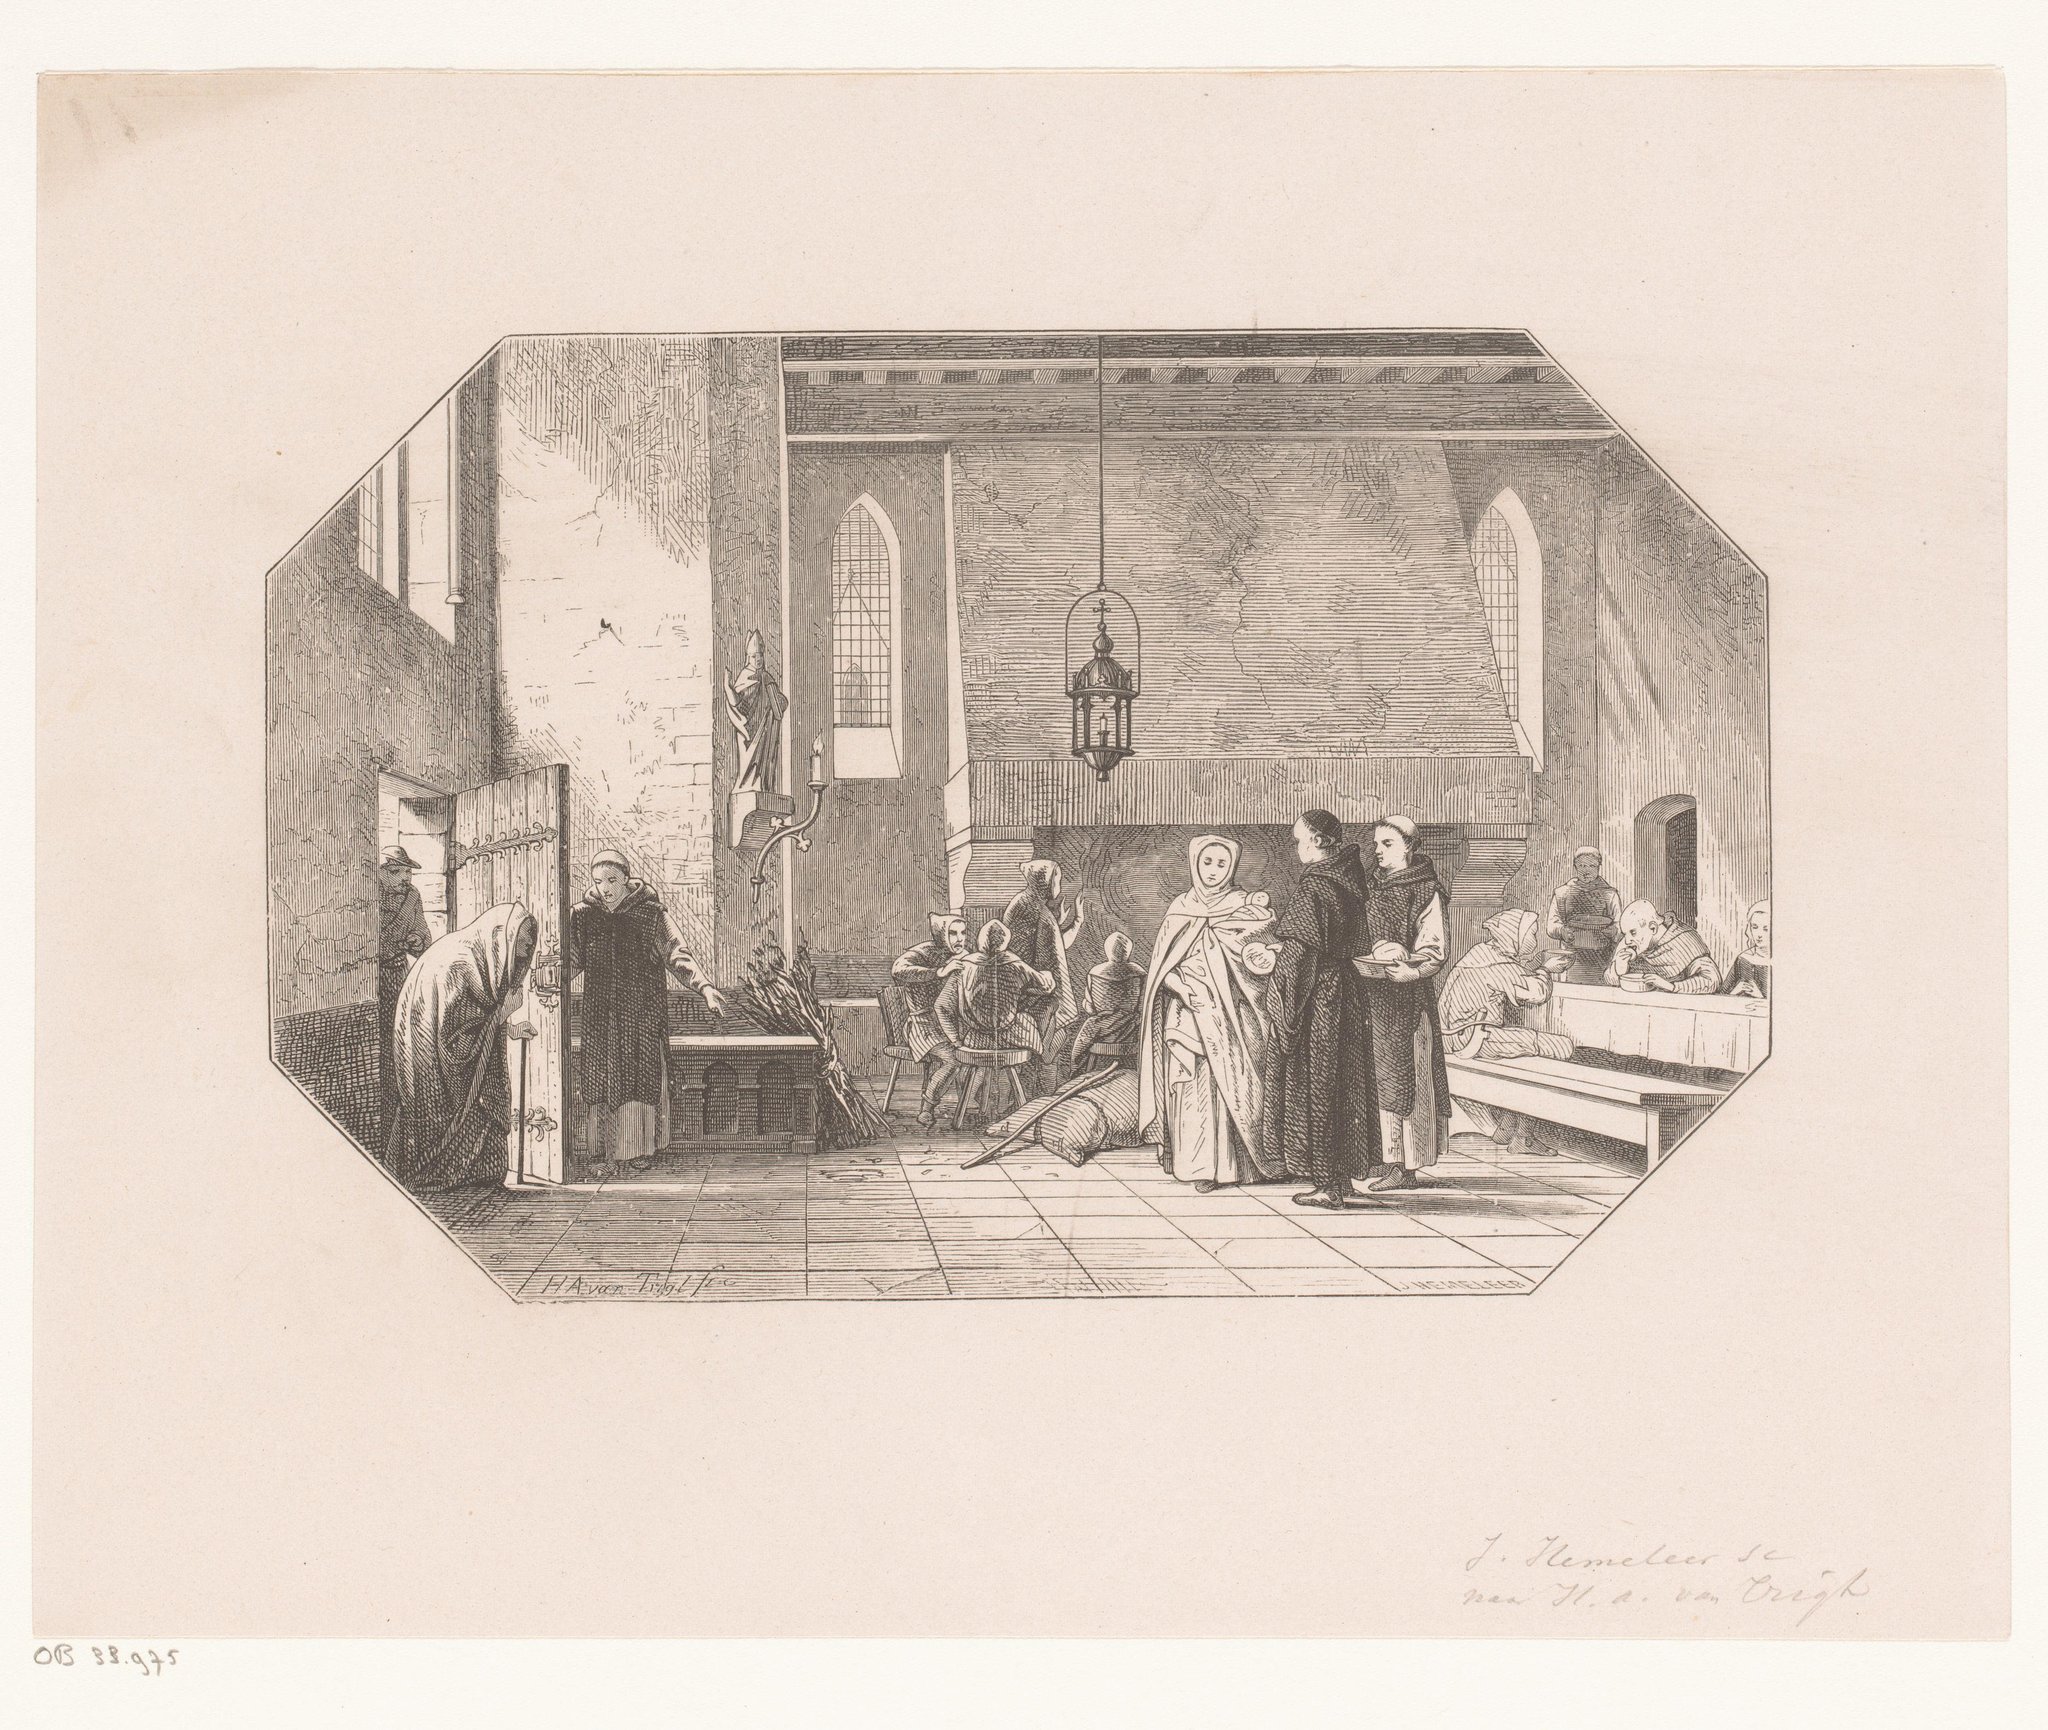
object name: print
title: Warme stove te Utrecht, 1366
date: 1840-1873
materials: paper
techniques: engraving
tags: giving alms or other charity, e.g.: handing out food, open hearth, fire-place, abbey, monastery, convent ~ roman catholic church, utrecht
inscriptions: collector's mark: Lugt 2228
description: Armen, daklozen en reizigers worden door monniken onthaald en onderdak en eten gegeven.